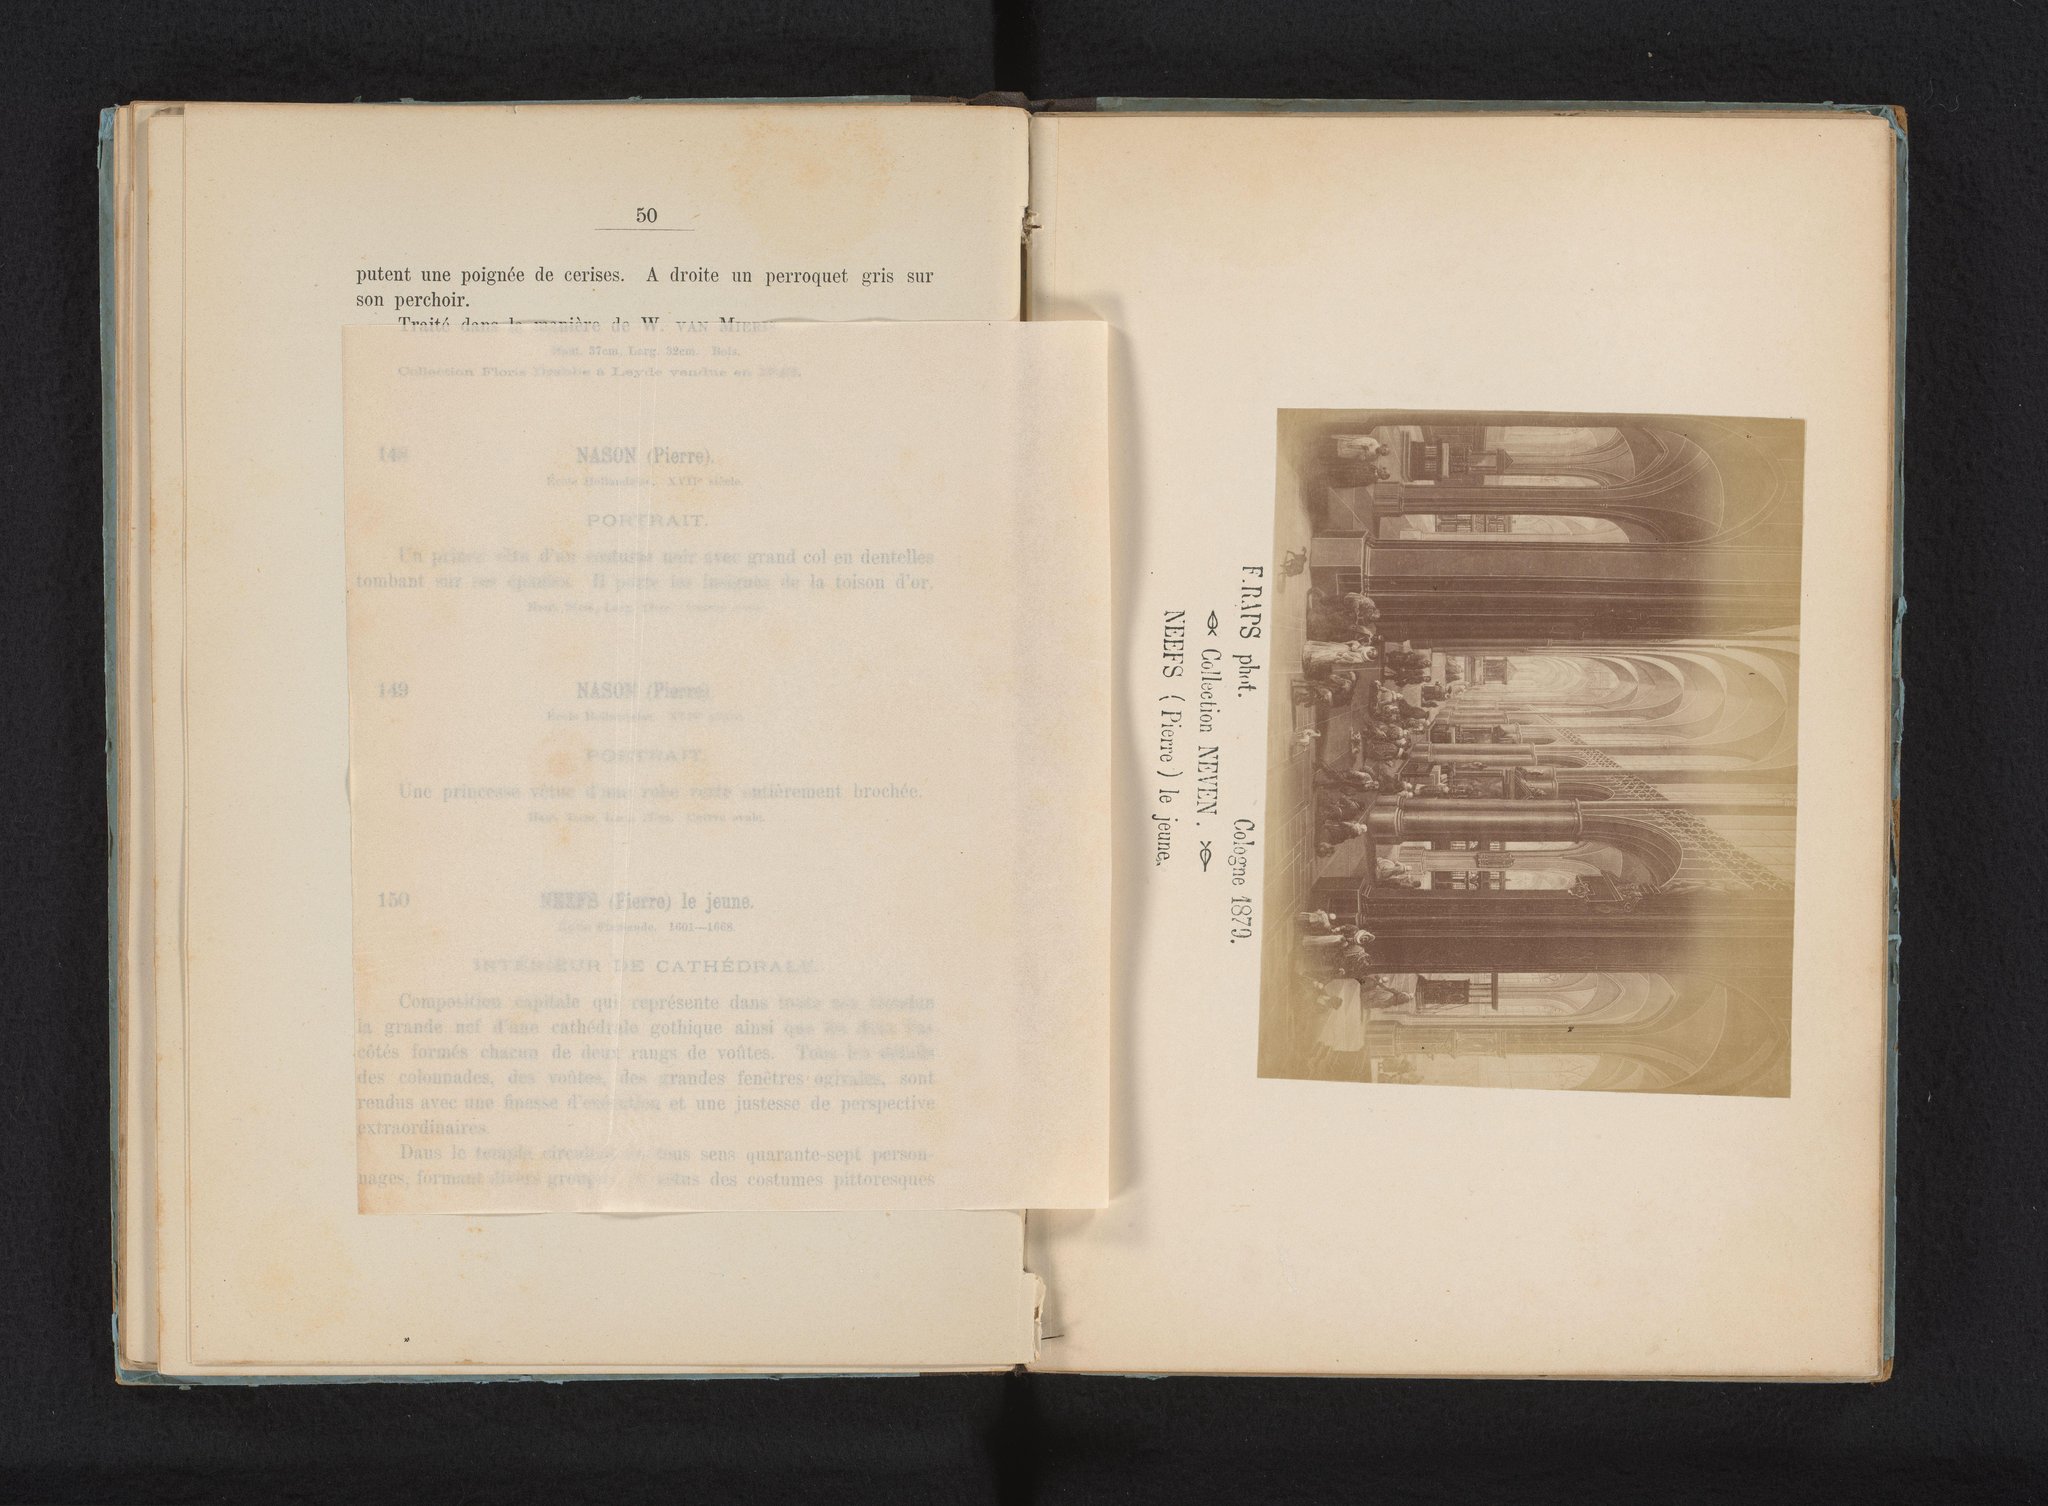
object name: page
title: Fotoreproductie van een schilderij van het interieur van de Onze-Lieve-Vrouwekathedraal te Antwerpen door Pieter Neefs II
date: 1879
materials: photographic support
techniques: albumen print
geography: cologne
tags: interior of church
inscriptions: inscription: ‘Collection NEVEN/ Neefs (Pierre) le jeune’